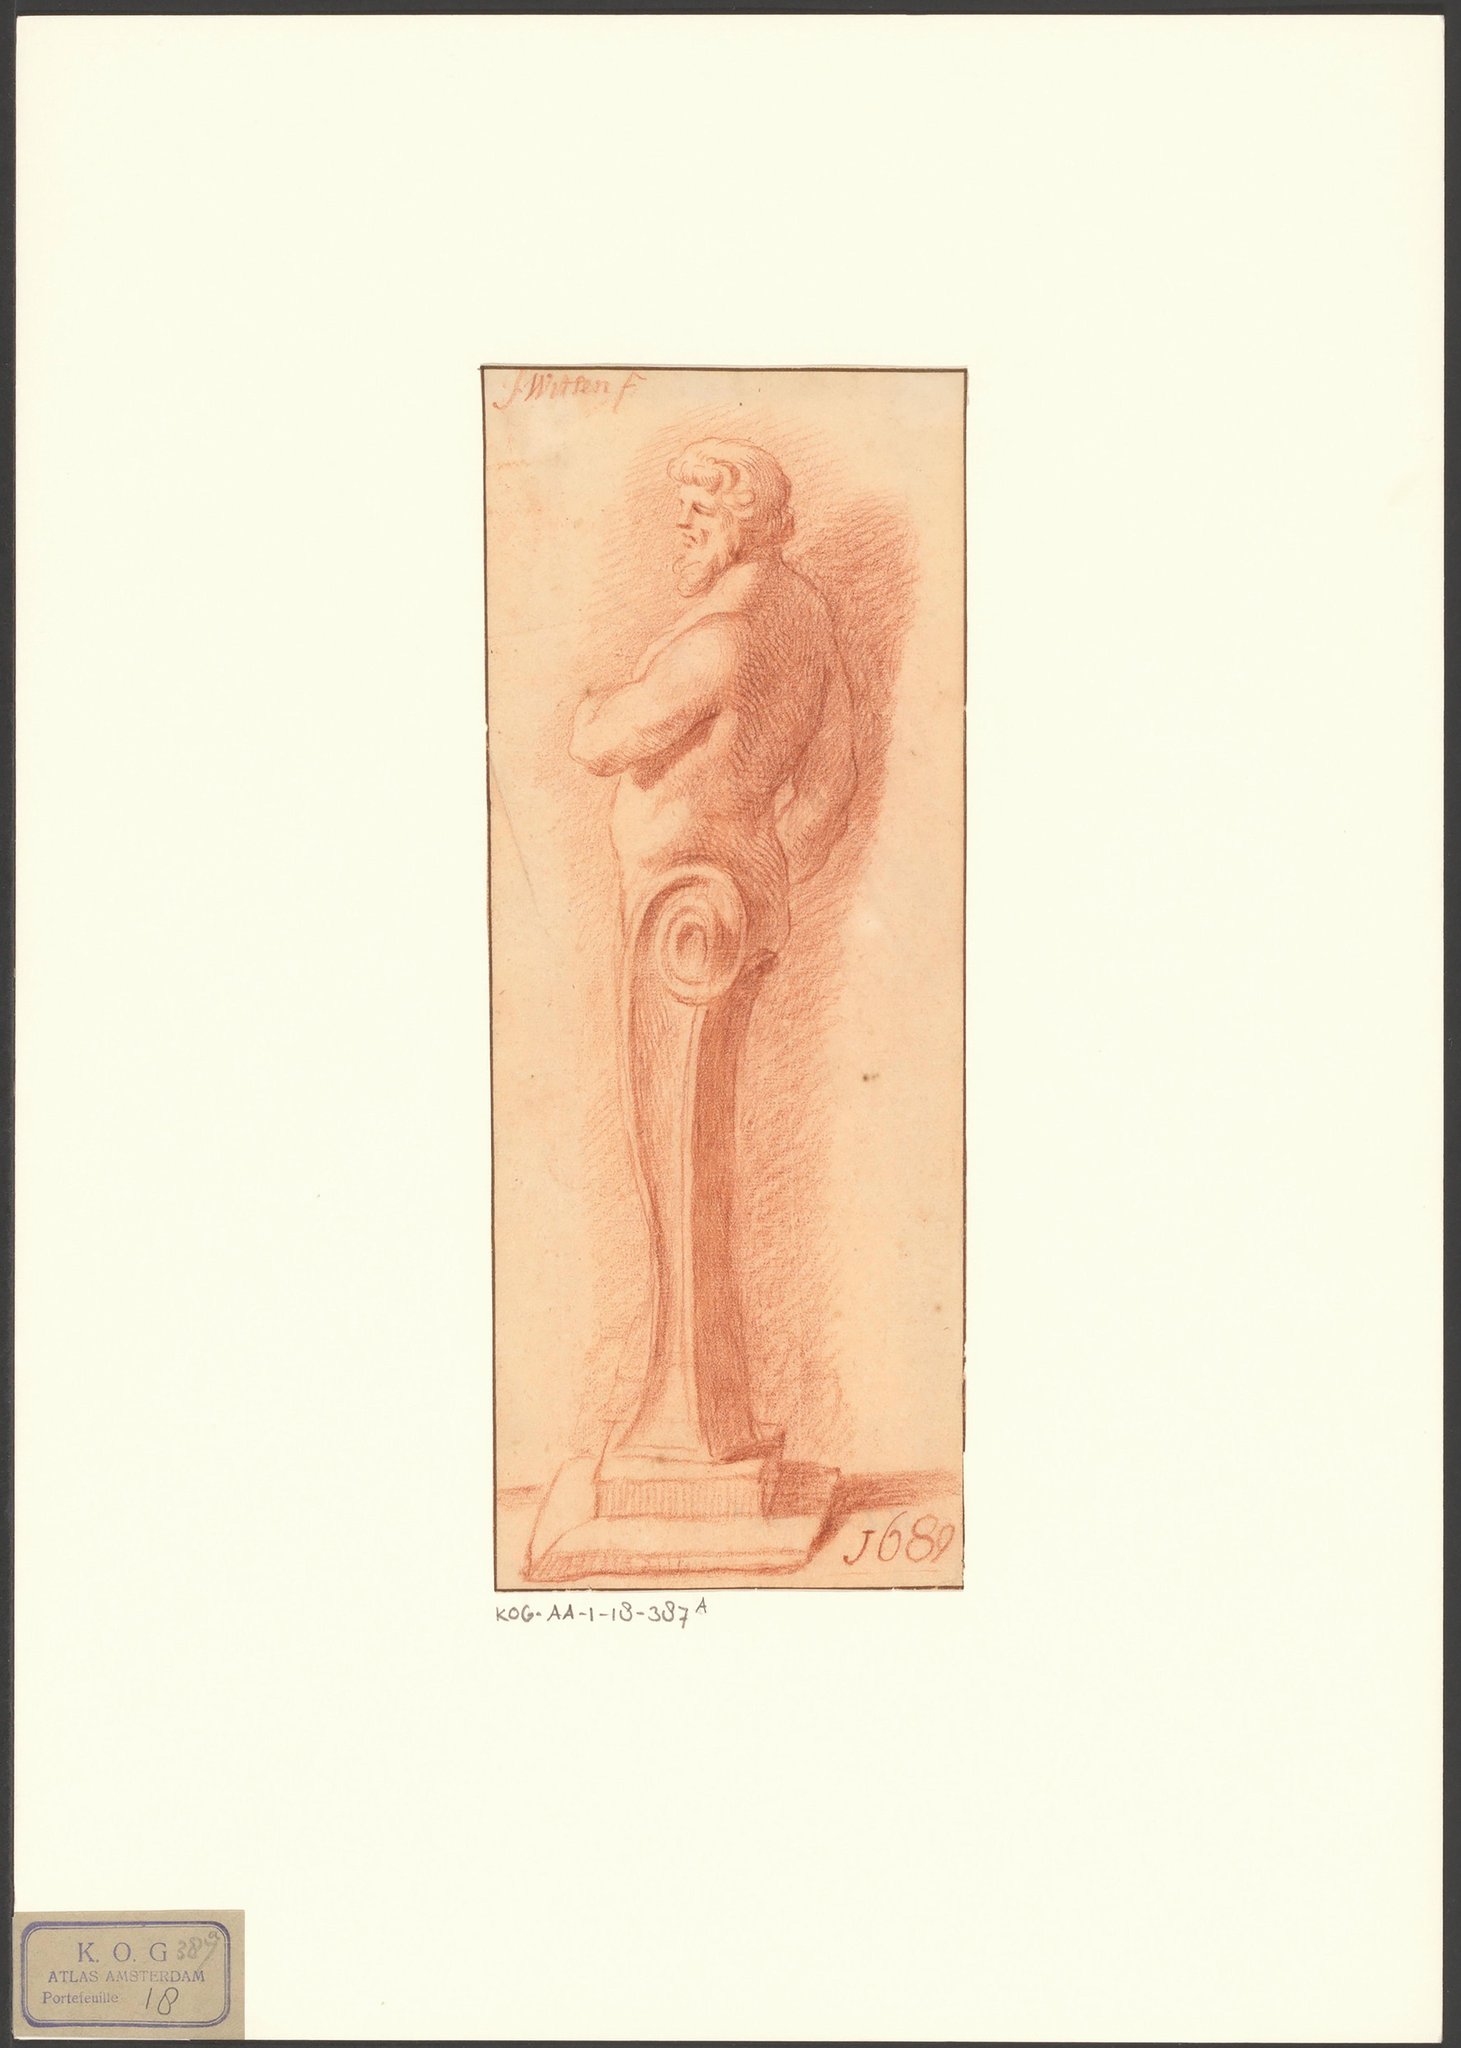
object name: drawing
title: Atlant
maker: jonas witsen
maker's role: mayor, print maker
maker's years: 1705-1767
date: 1715-1767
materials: chalk, paper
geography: amsterdam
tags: column, pillar ~ architecture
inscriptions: inscription: ‘Port. 18-387a’, collector's mark: ‘18’ Lugt 1641b, signature: ‘J Witsen f / 1689’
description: Onderwerpsrubriek binnen de Atlas Amsterdam: Herinneringen aan regeringsleden en hunne huisgezinnen. [voor 1800].